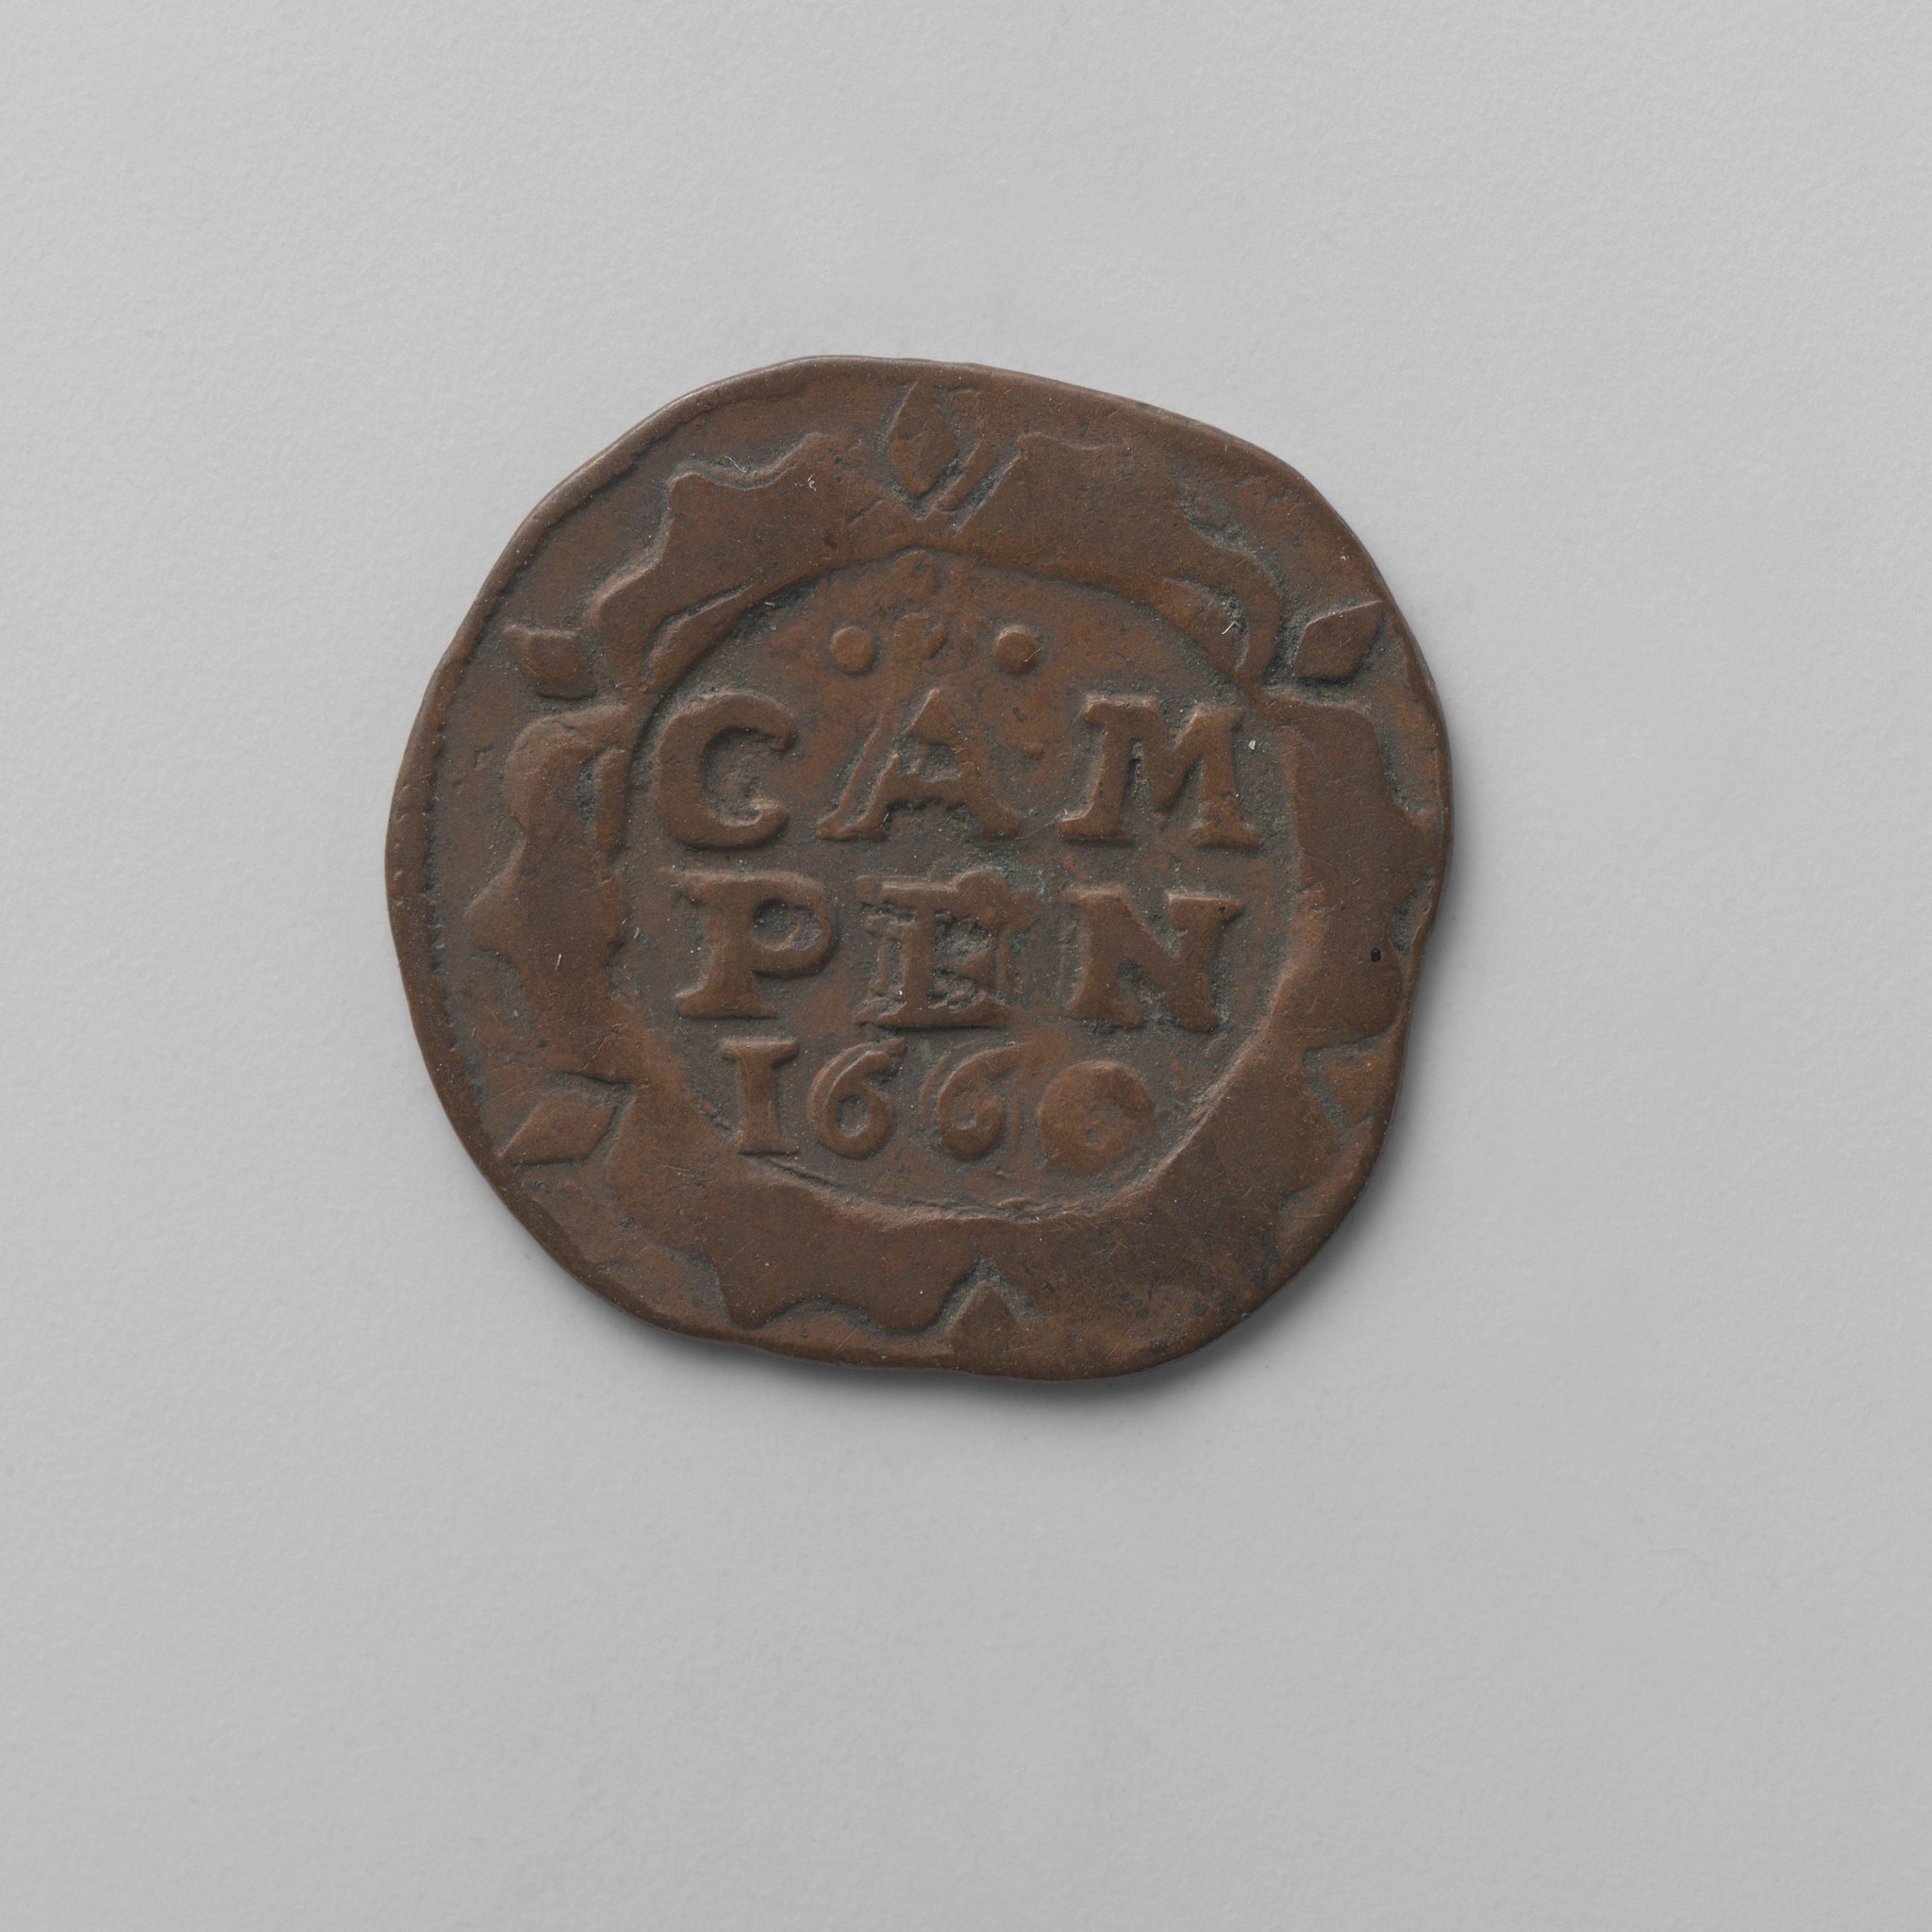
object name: coin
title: Kampen, duit, 1660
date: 1660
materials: copper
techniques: striking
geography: kampen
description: Koperen munt. Voorzijde: gekroond versierd stadswapenschild. Keerzijde: binnen een versierde rand tweeregelig opschrift, waaronder jaartal.